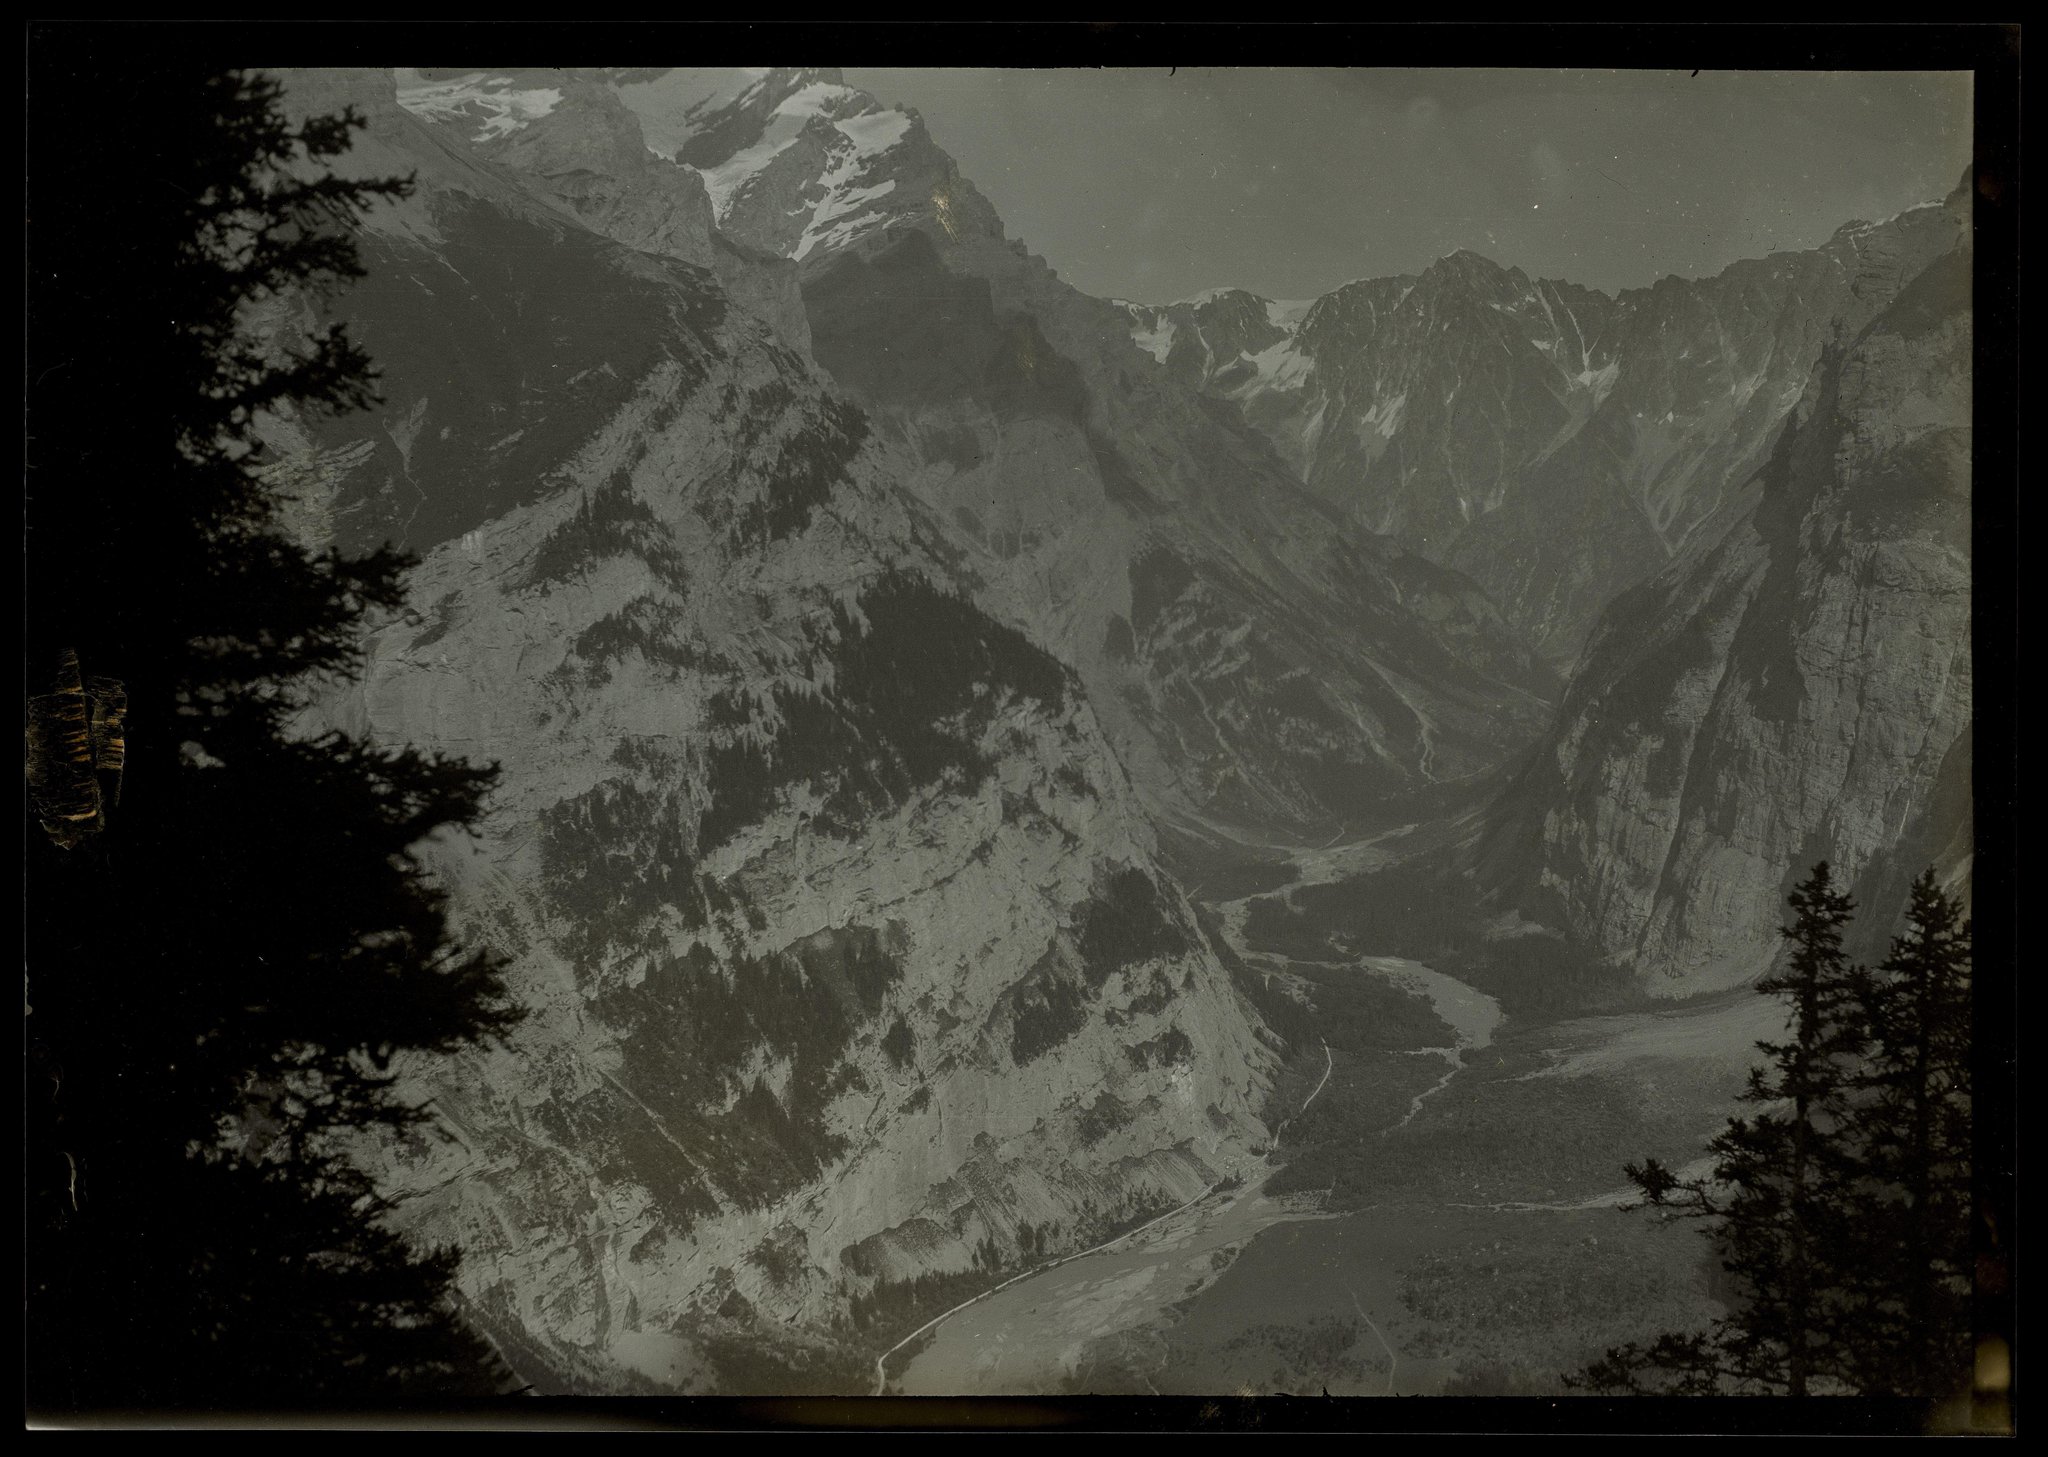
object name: negative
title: Filmnegatief met opname van Basel, Thun, Kandersteg of Gemmi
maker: Anonymous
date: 1921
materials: film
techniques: gelatin silver negative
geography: switzerland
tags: switzerland